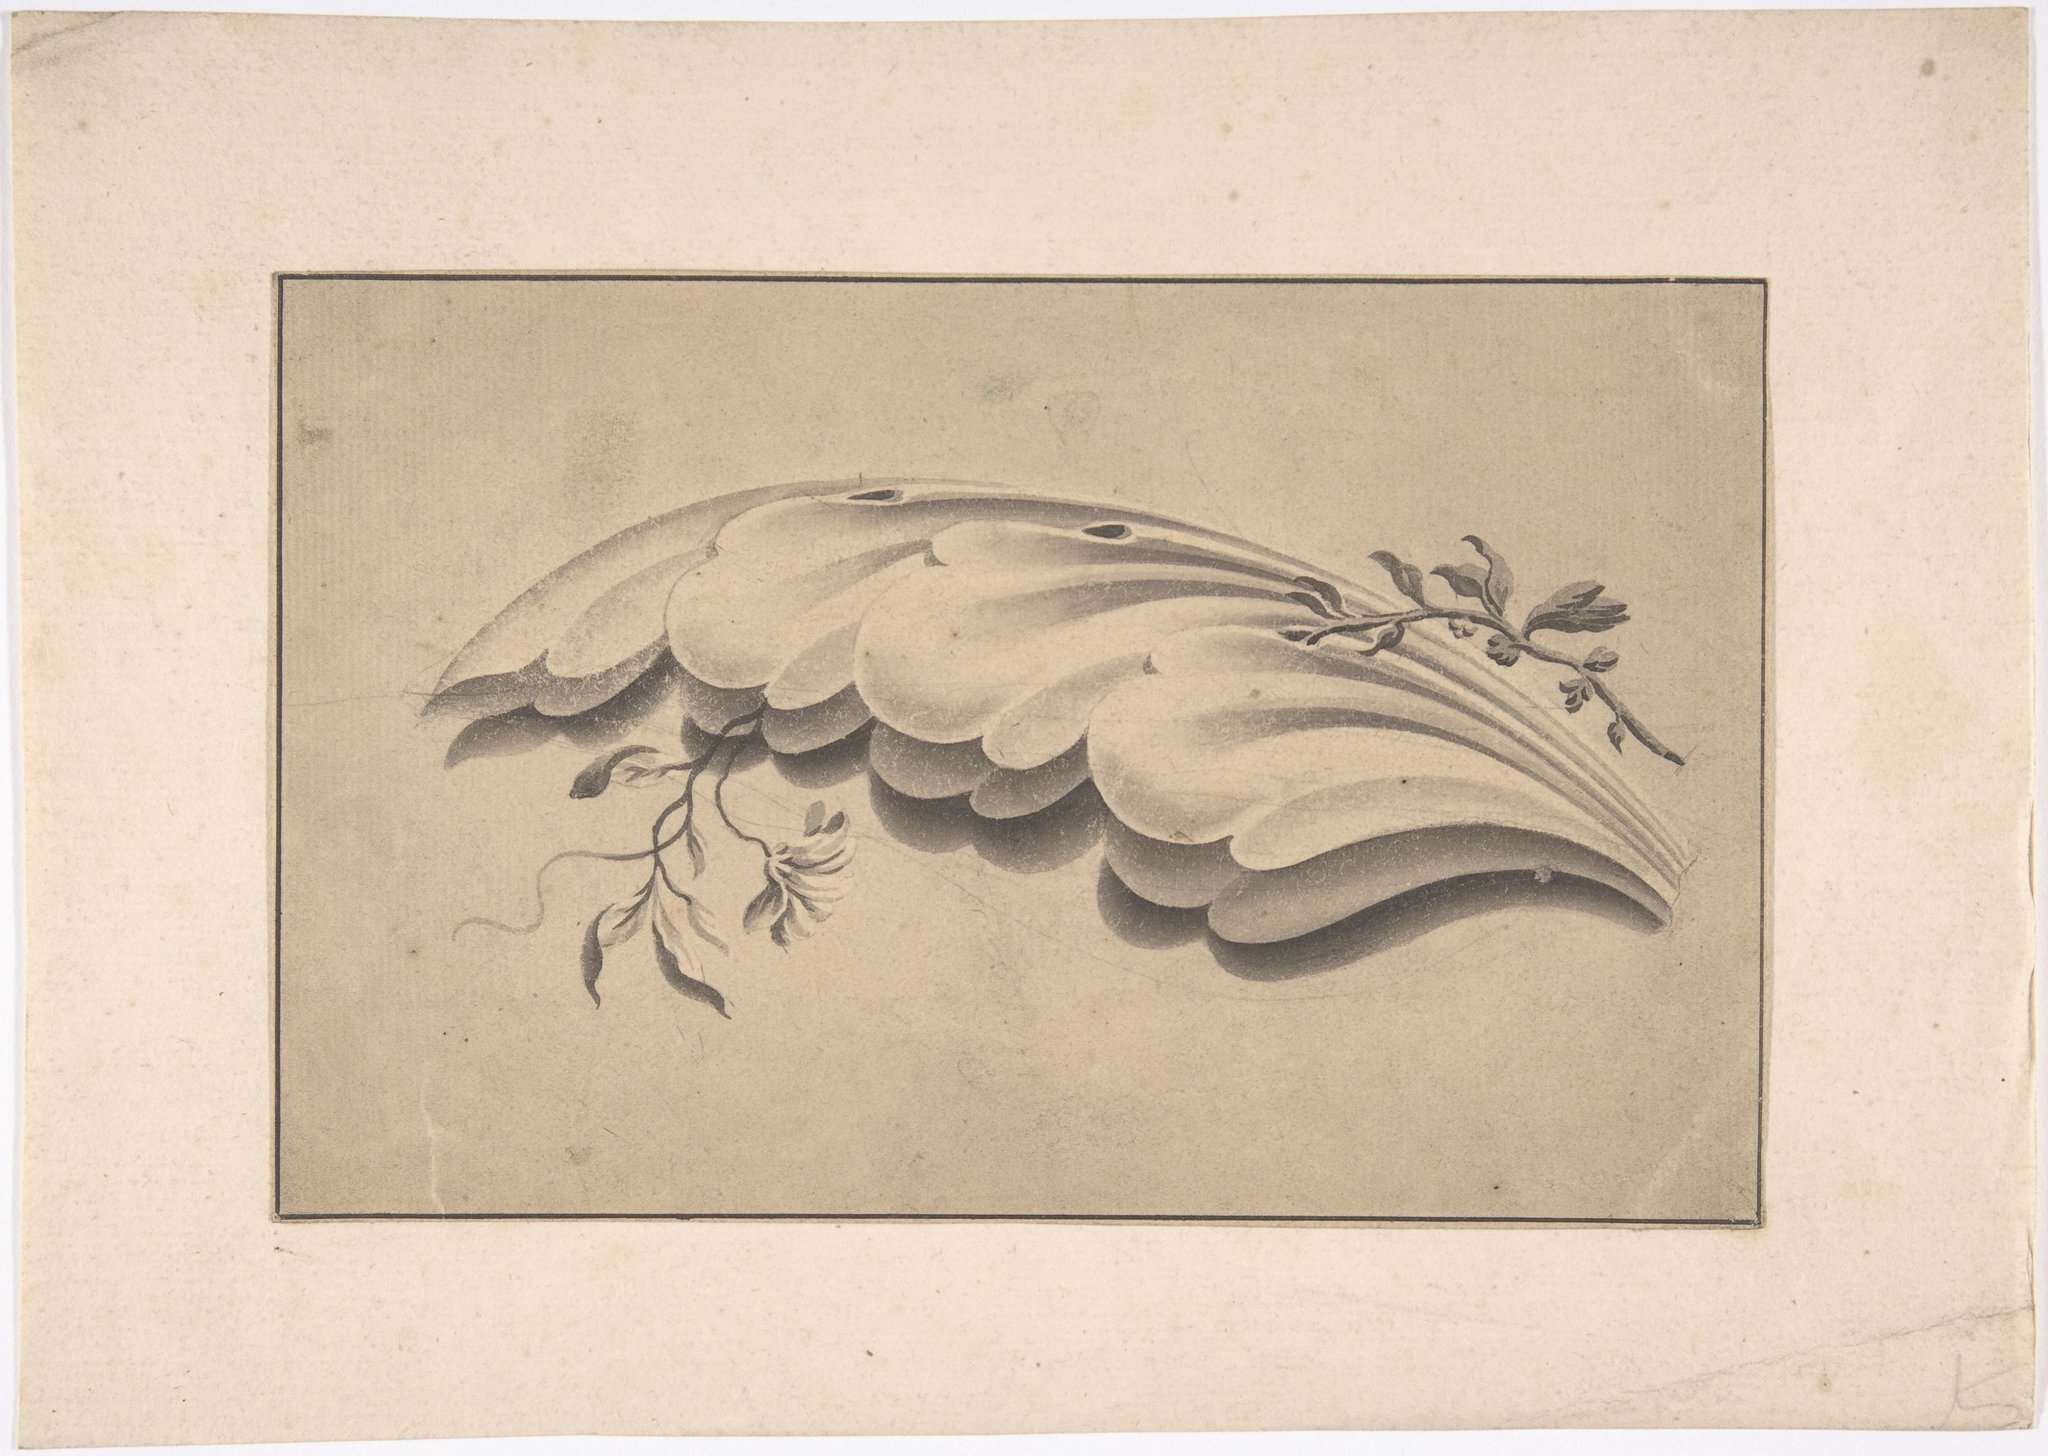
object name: drawing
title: Acanthus Leaf and Flowering Vine Ornament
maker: anonymous, british, 19th century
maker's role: artist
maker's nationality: british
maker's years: 1800-1900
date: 1801-1900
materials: ink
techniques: brush, pen, wash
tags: flowers,leaves